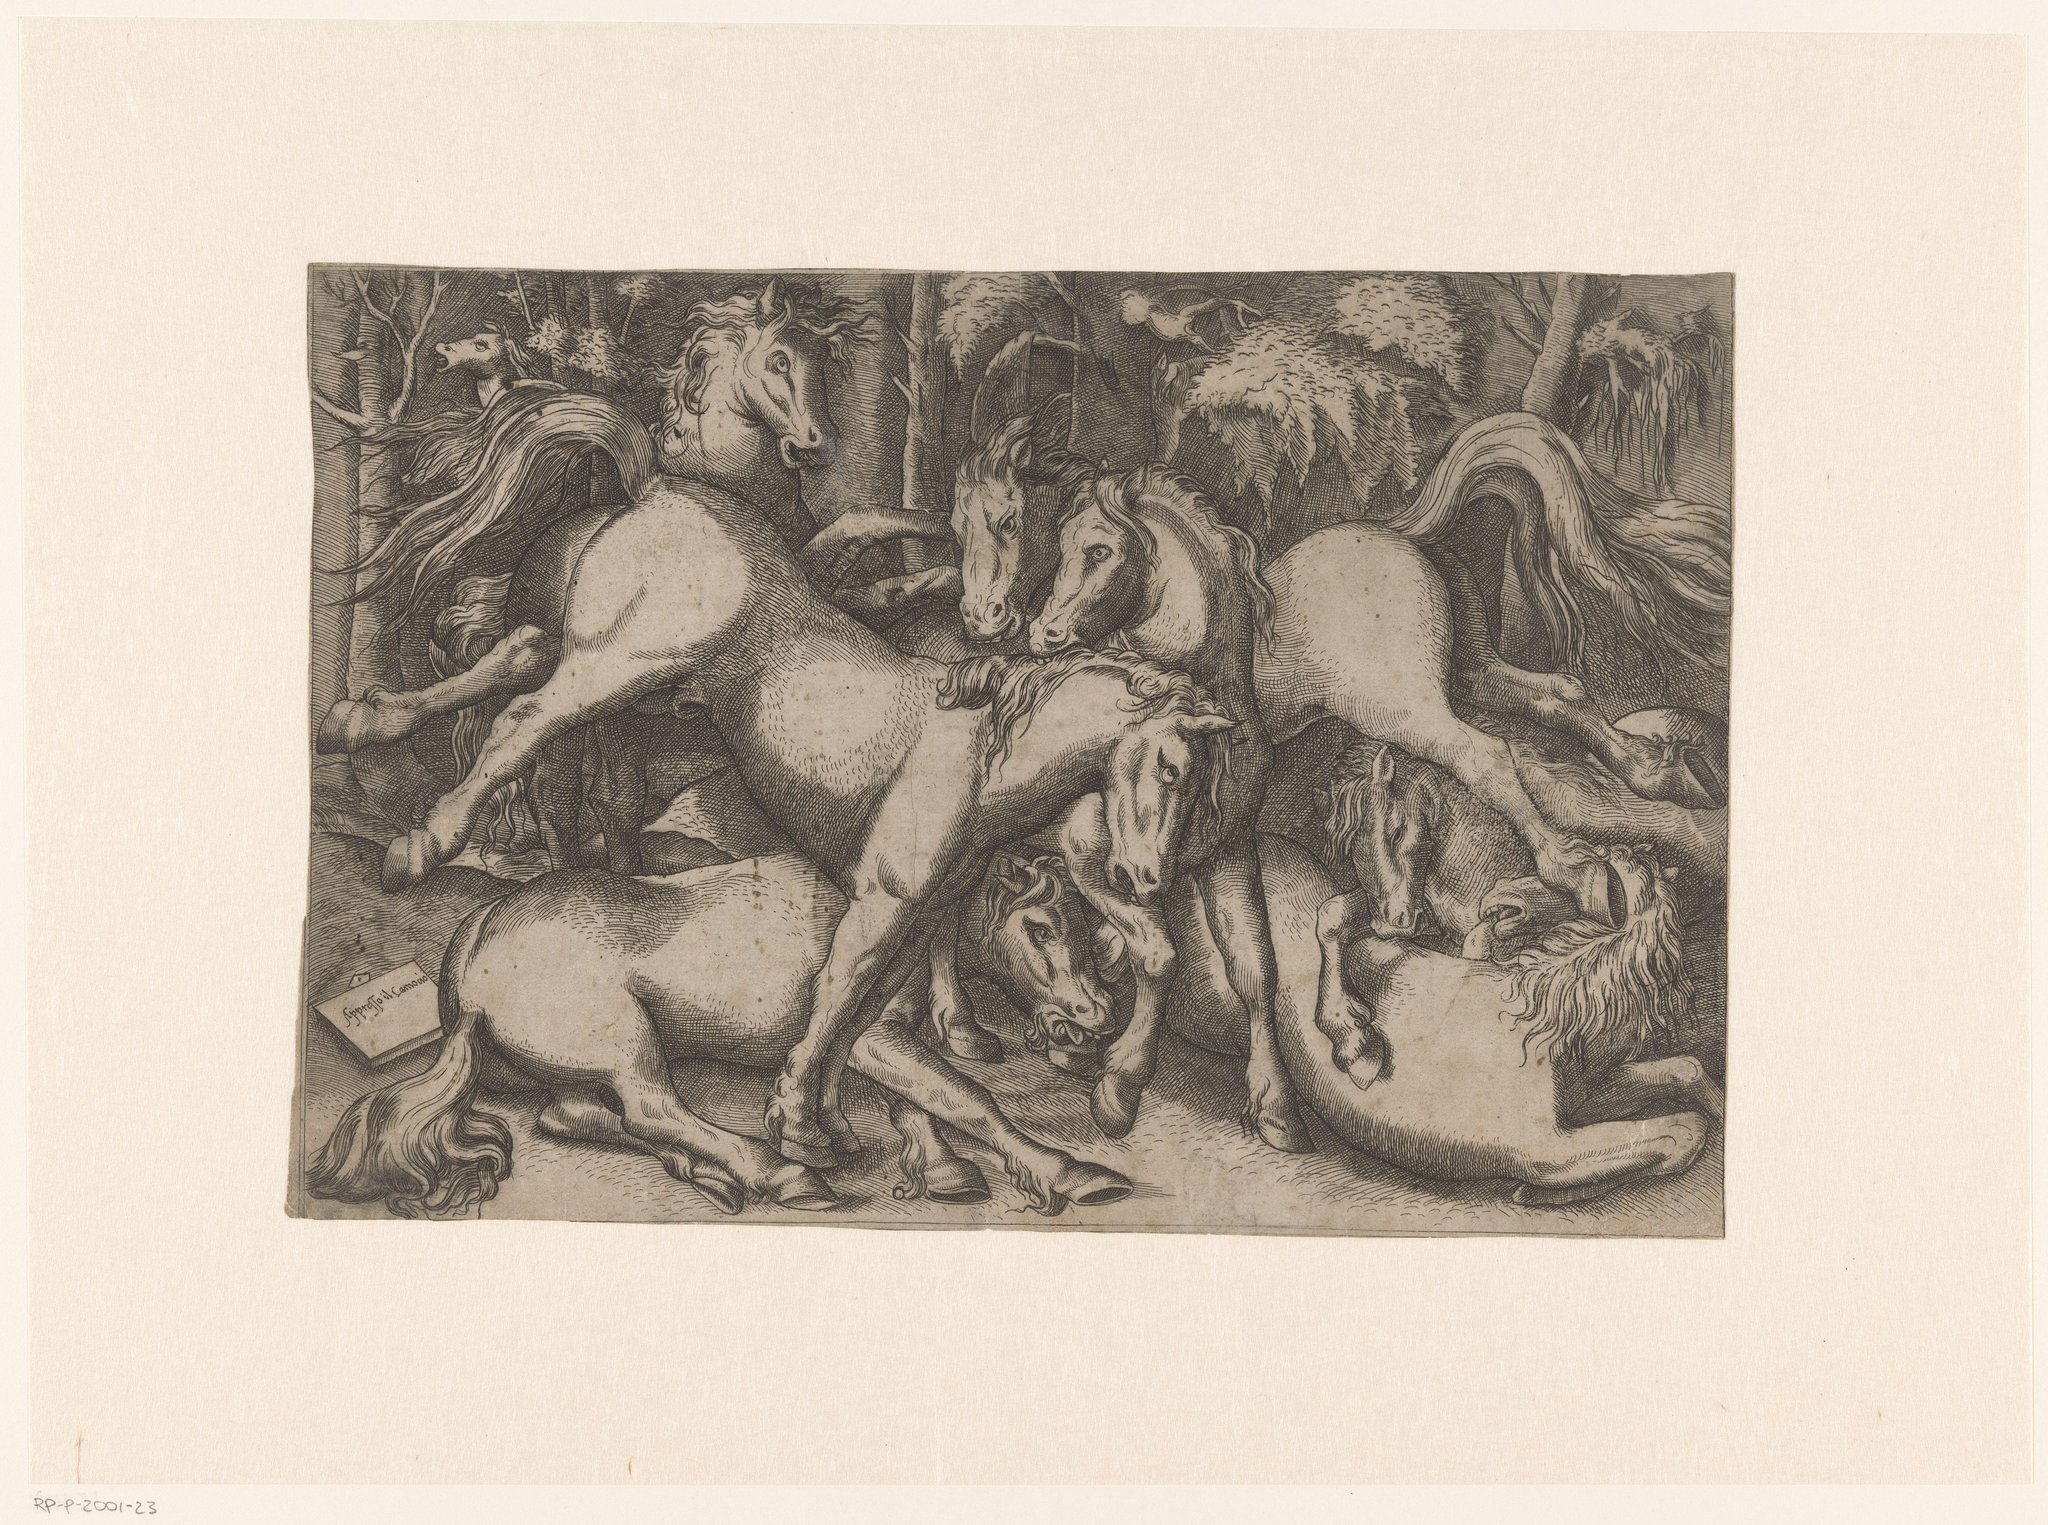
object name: print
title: Vechtende paarden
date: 1511-1575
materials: paper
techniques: etching, intaglio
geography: italy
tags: fighting horses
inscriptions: collector's mark: Lugt 2228, collector's mark: Lugt 2760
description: Een groep van zeven vechtende paarden. Drie van de paarden liggen op de grond.